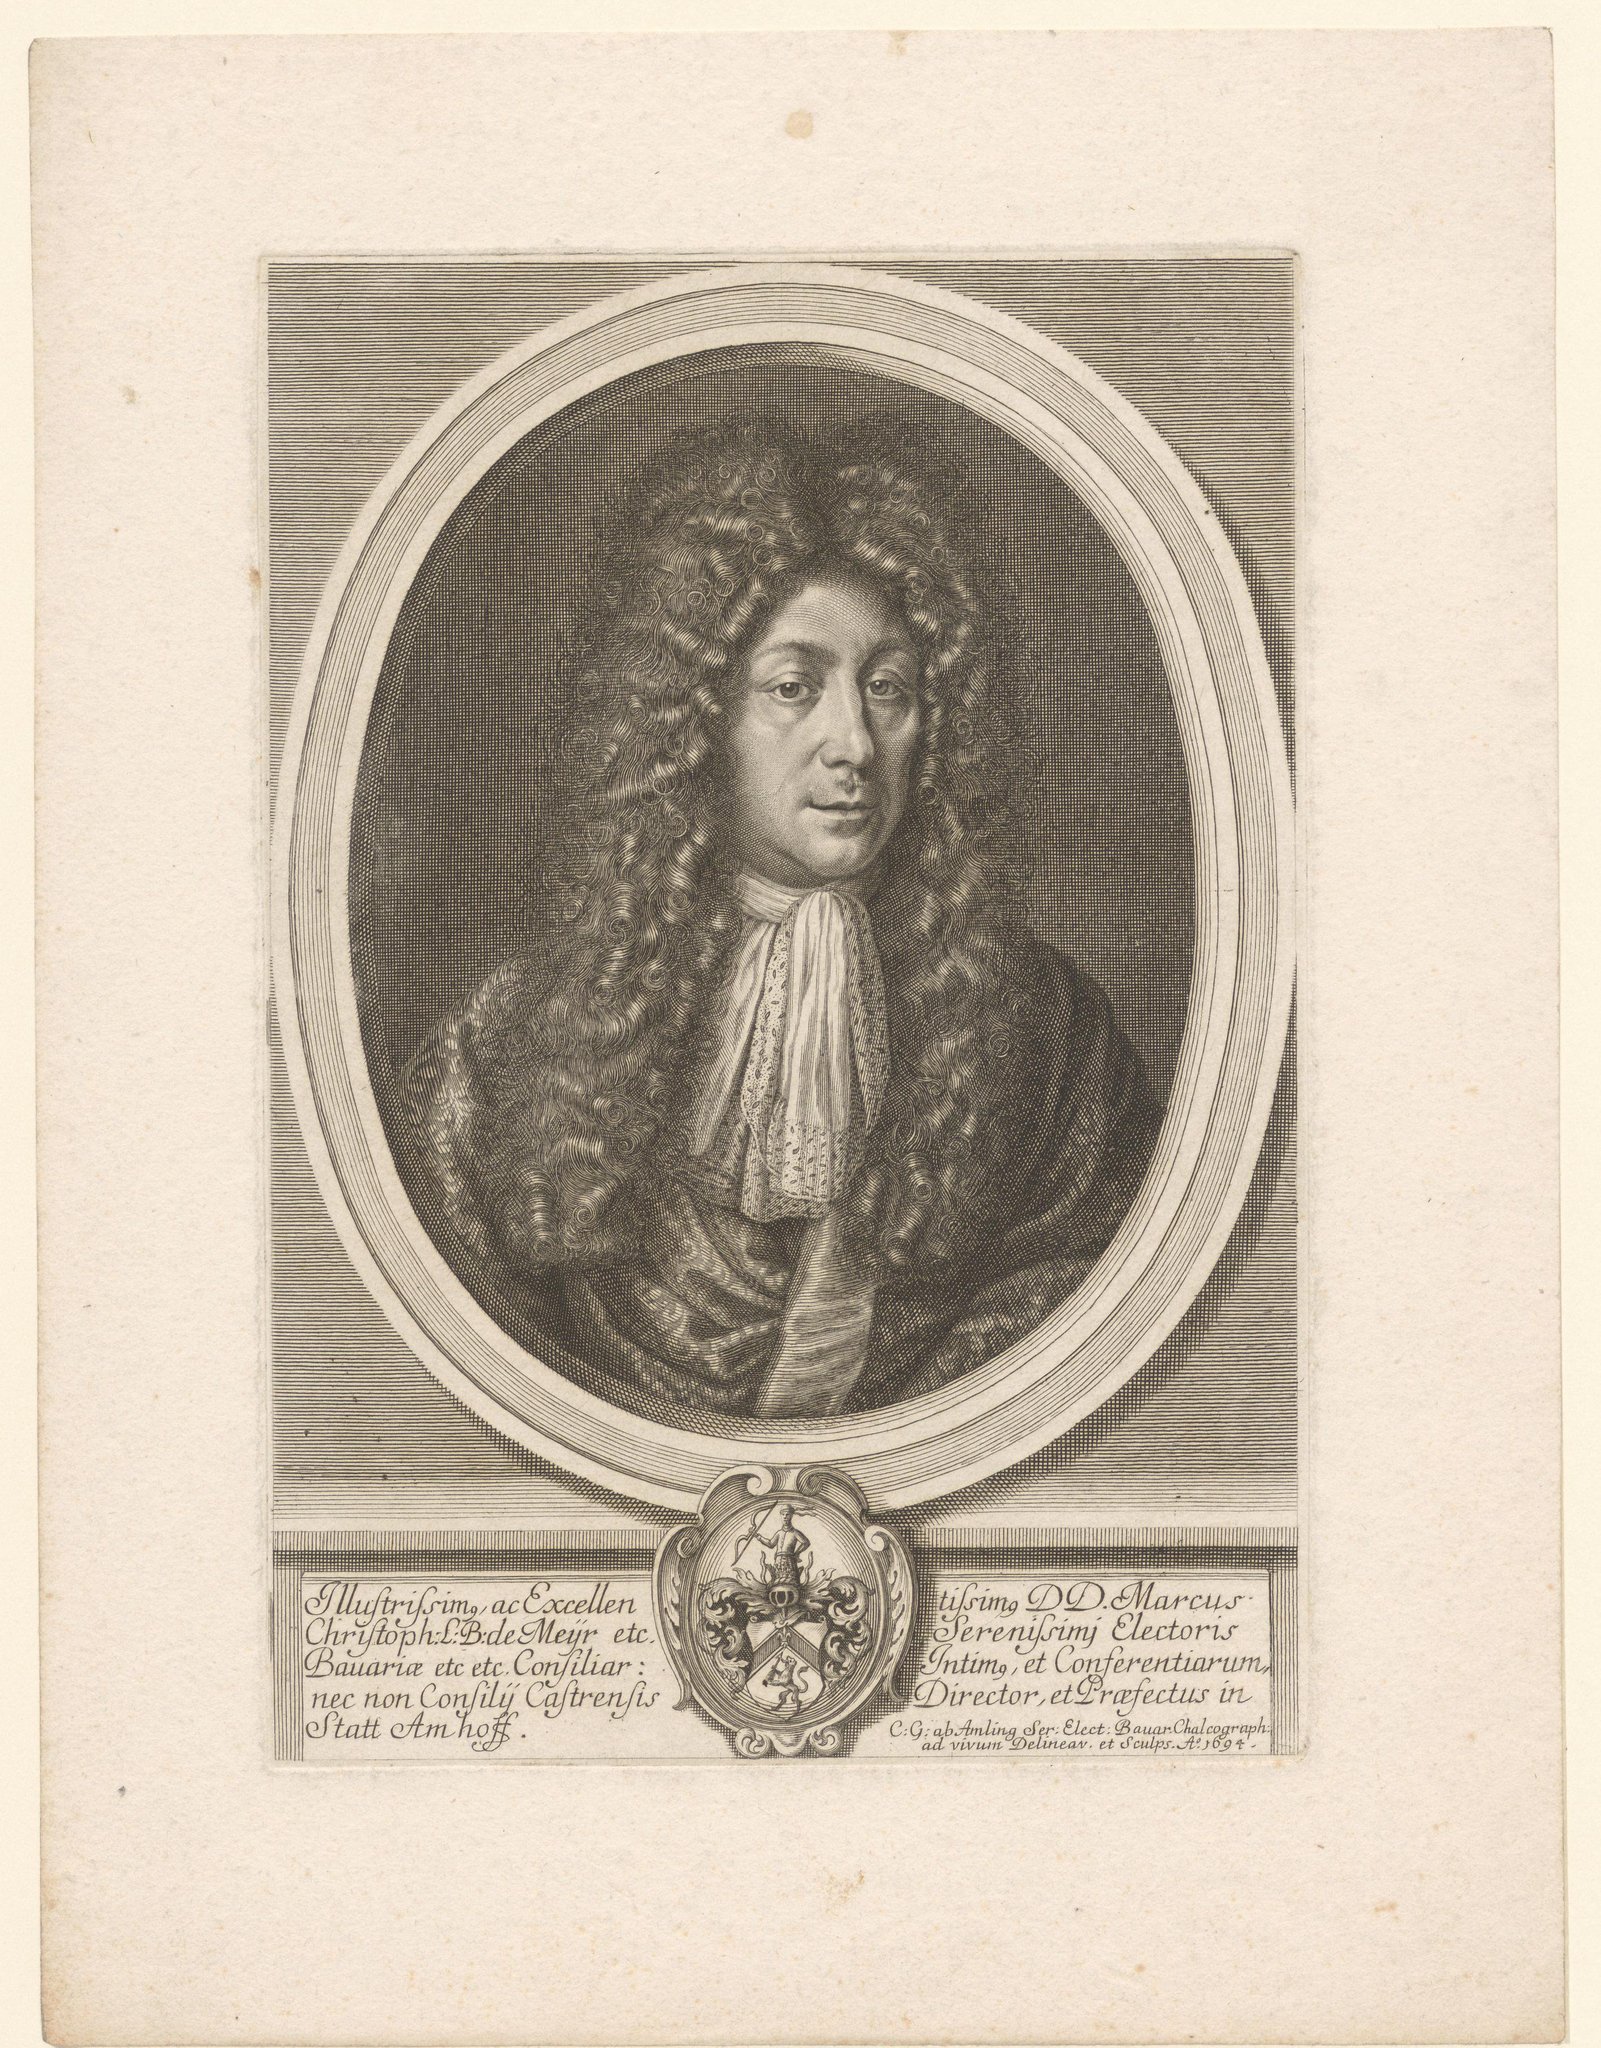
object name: print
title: Portret van Markus Christoph von Mayer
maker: karl gustav amling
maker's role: print maker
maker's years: 1651-1702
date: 1694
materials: paper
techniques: engraving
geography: munich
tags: historical persons, armorial bearing, heraldry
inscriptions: collector's mark: Lugt 2228